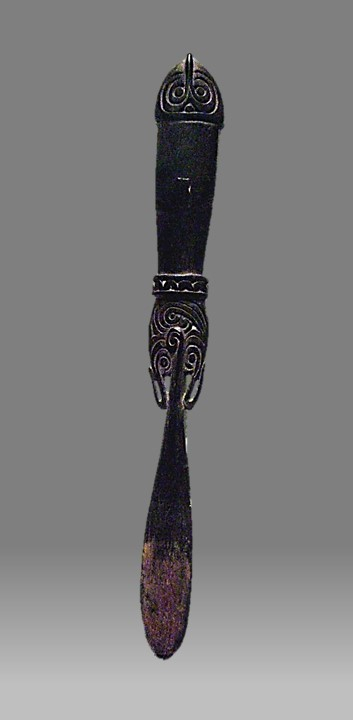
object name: lime spatula time marker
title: Time Marker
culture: melanesian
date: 1867-1900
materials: wood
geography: papua new guinea